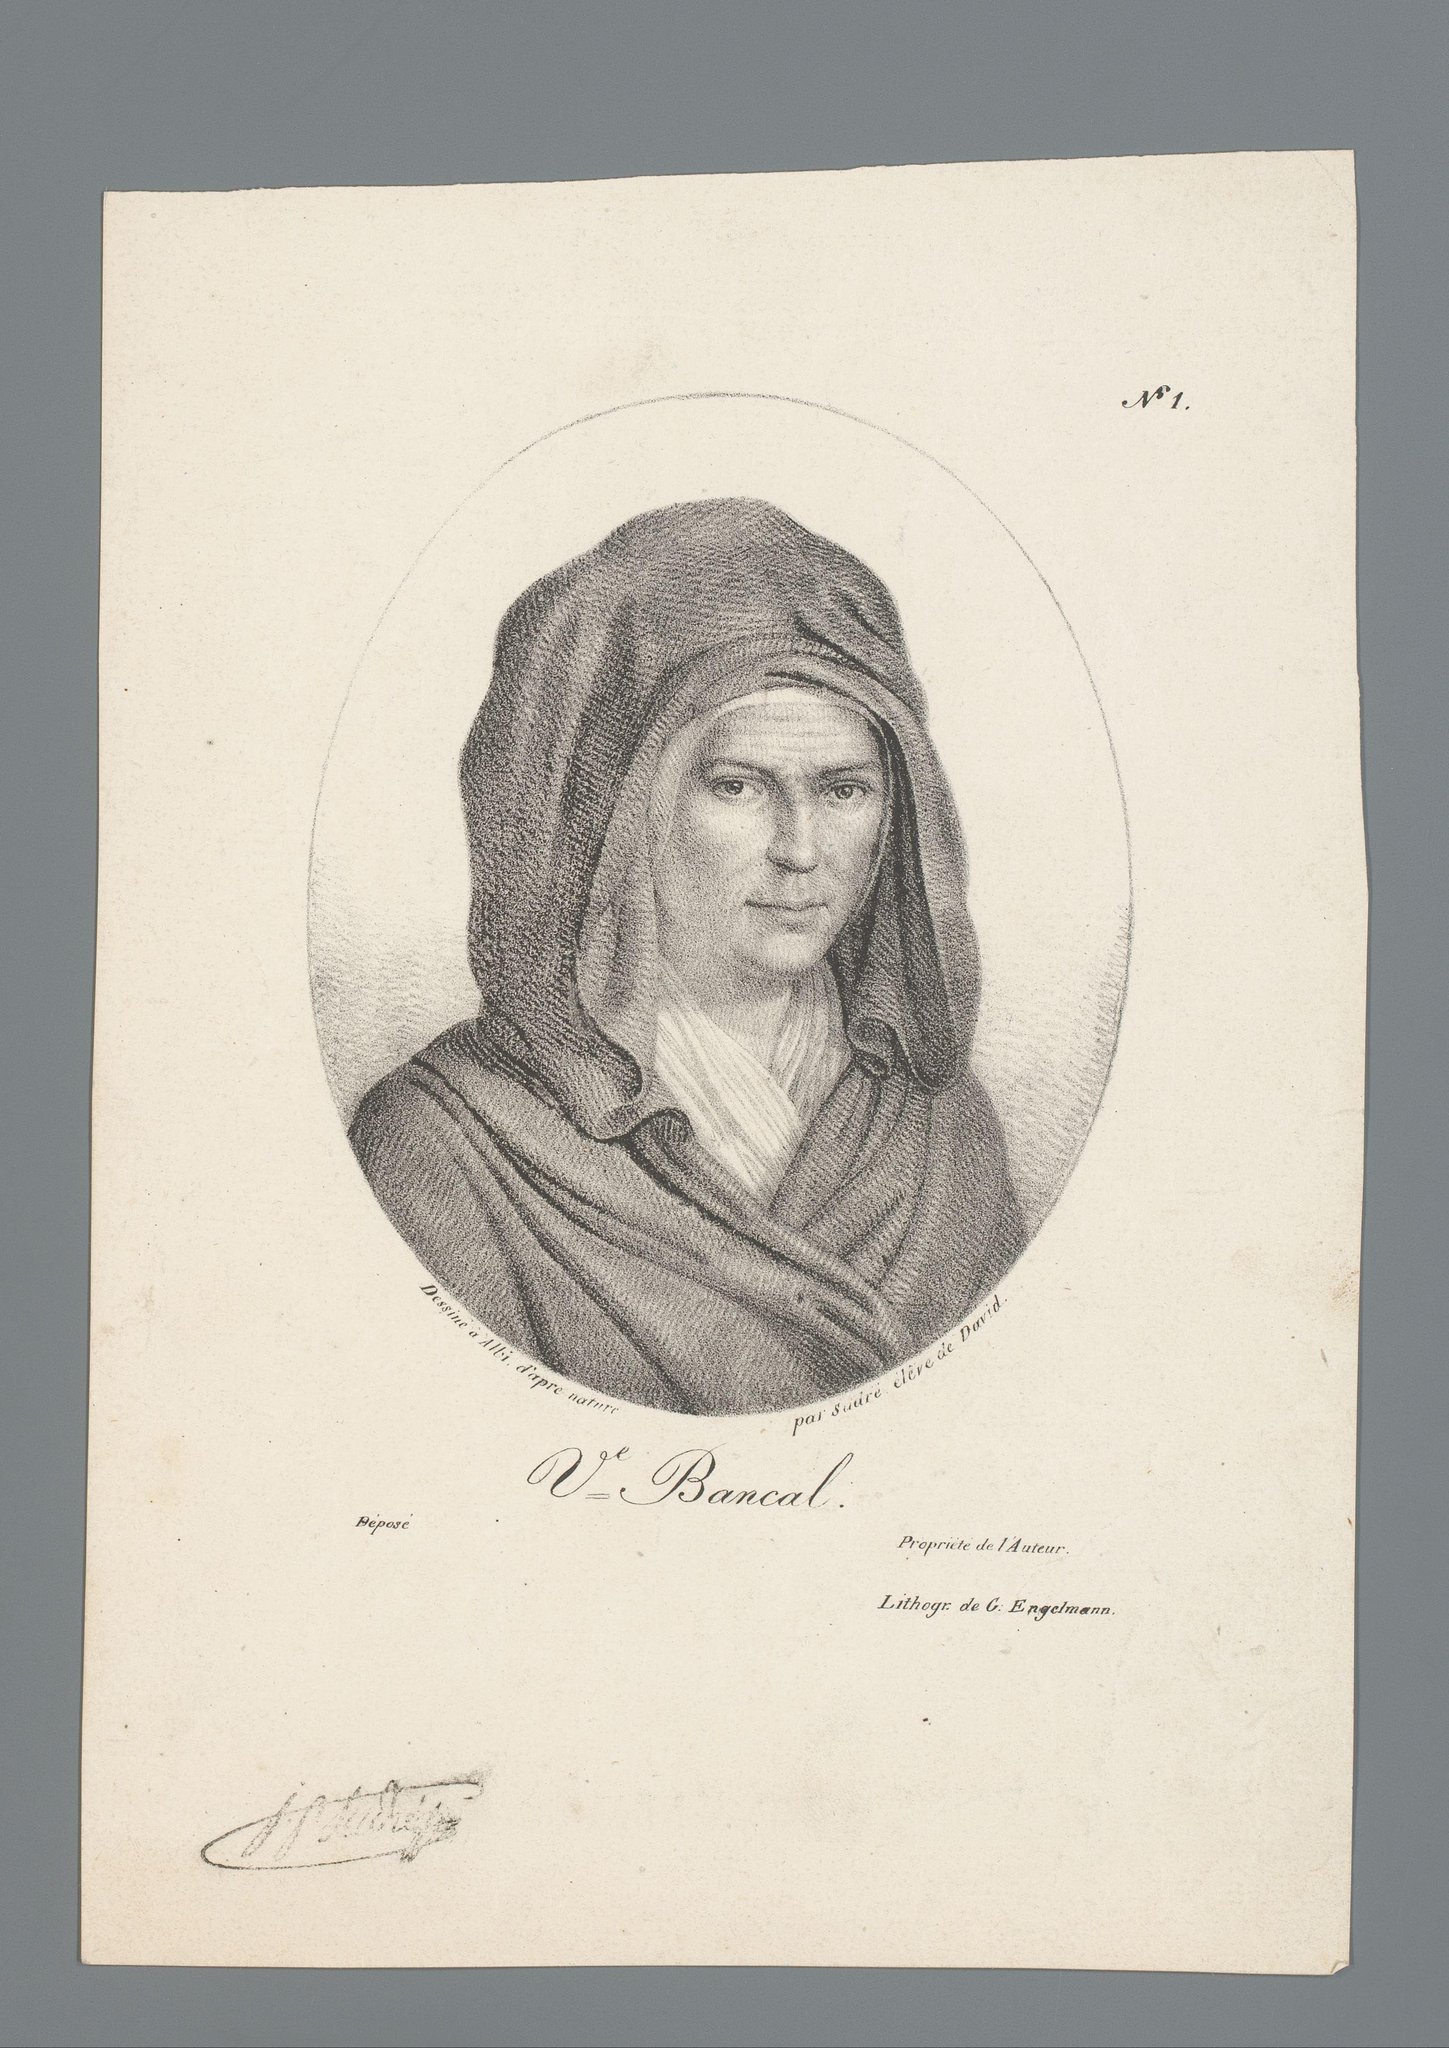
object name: print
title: Hoofdpersonages in de affaire-Fualdès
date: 1818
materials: paper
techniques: lithograph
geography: paris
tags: historical persons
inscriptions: stamp: Lugt 2325b, collector's mark: Lugt 2228